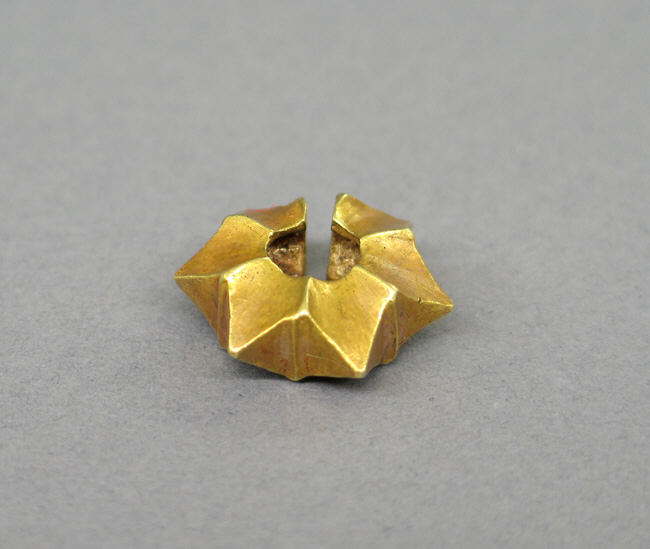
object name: ear clip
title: Ear Clip in the Shape of a Starfruit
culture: indonesian, javanese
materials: gold